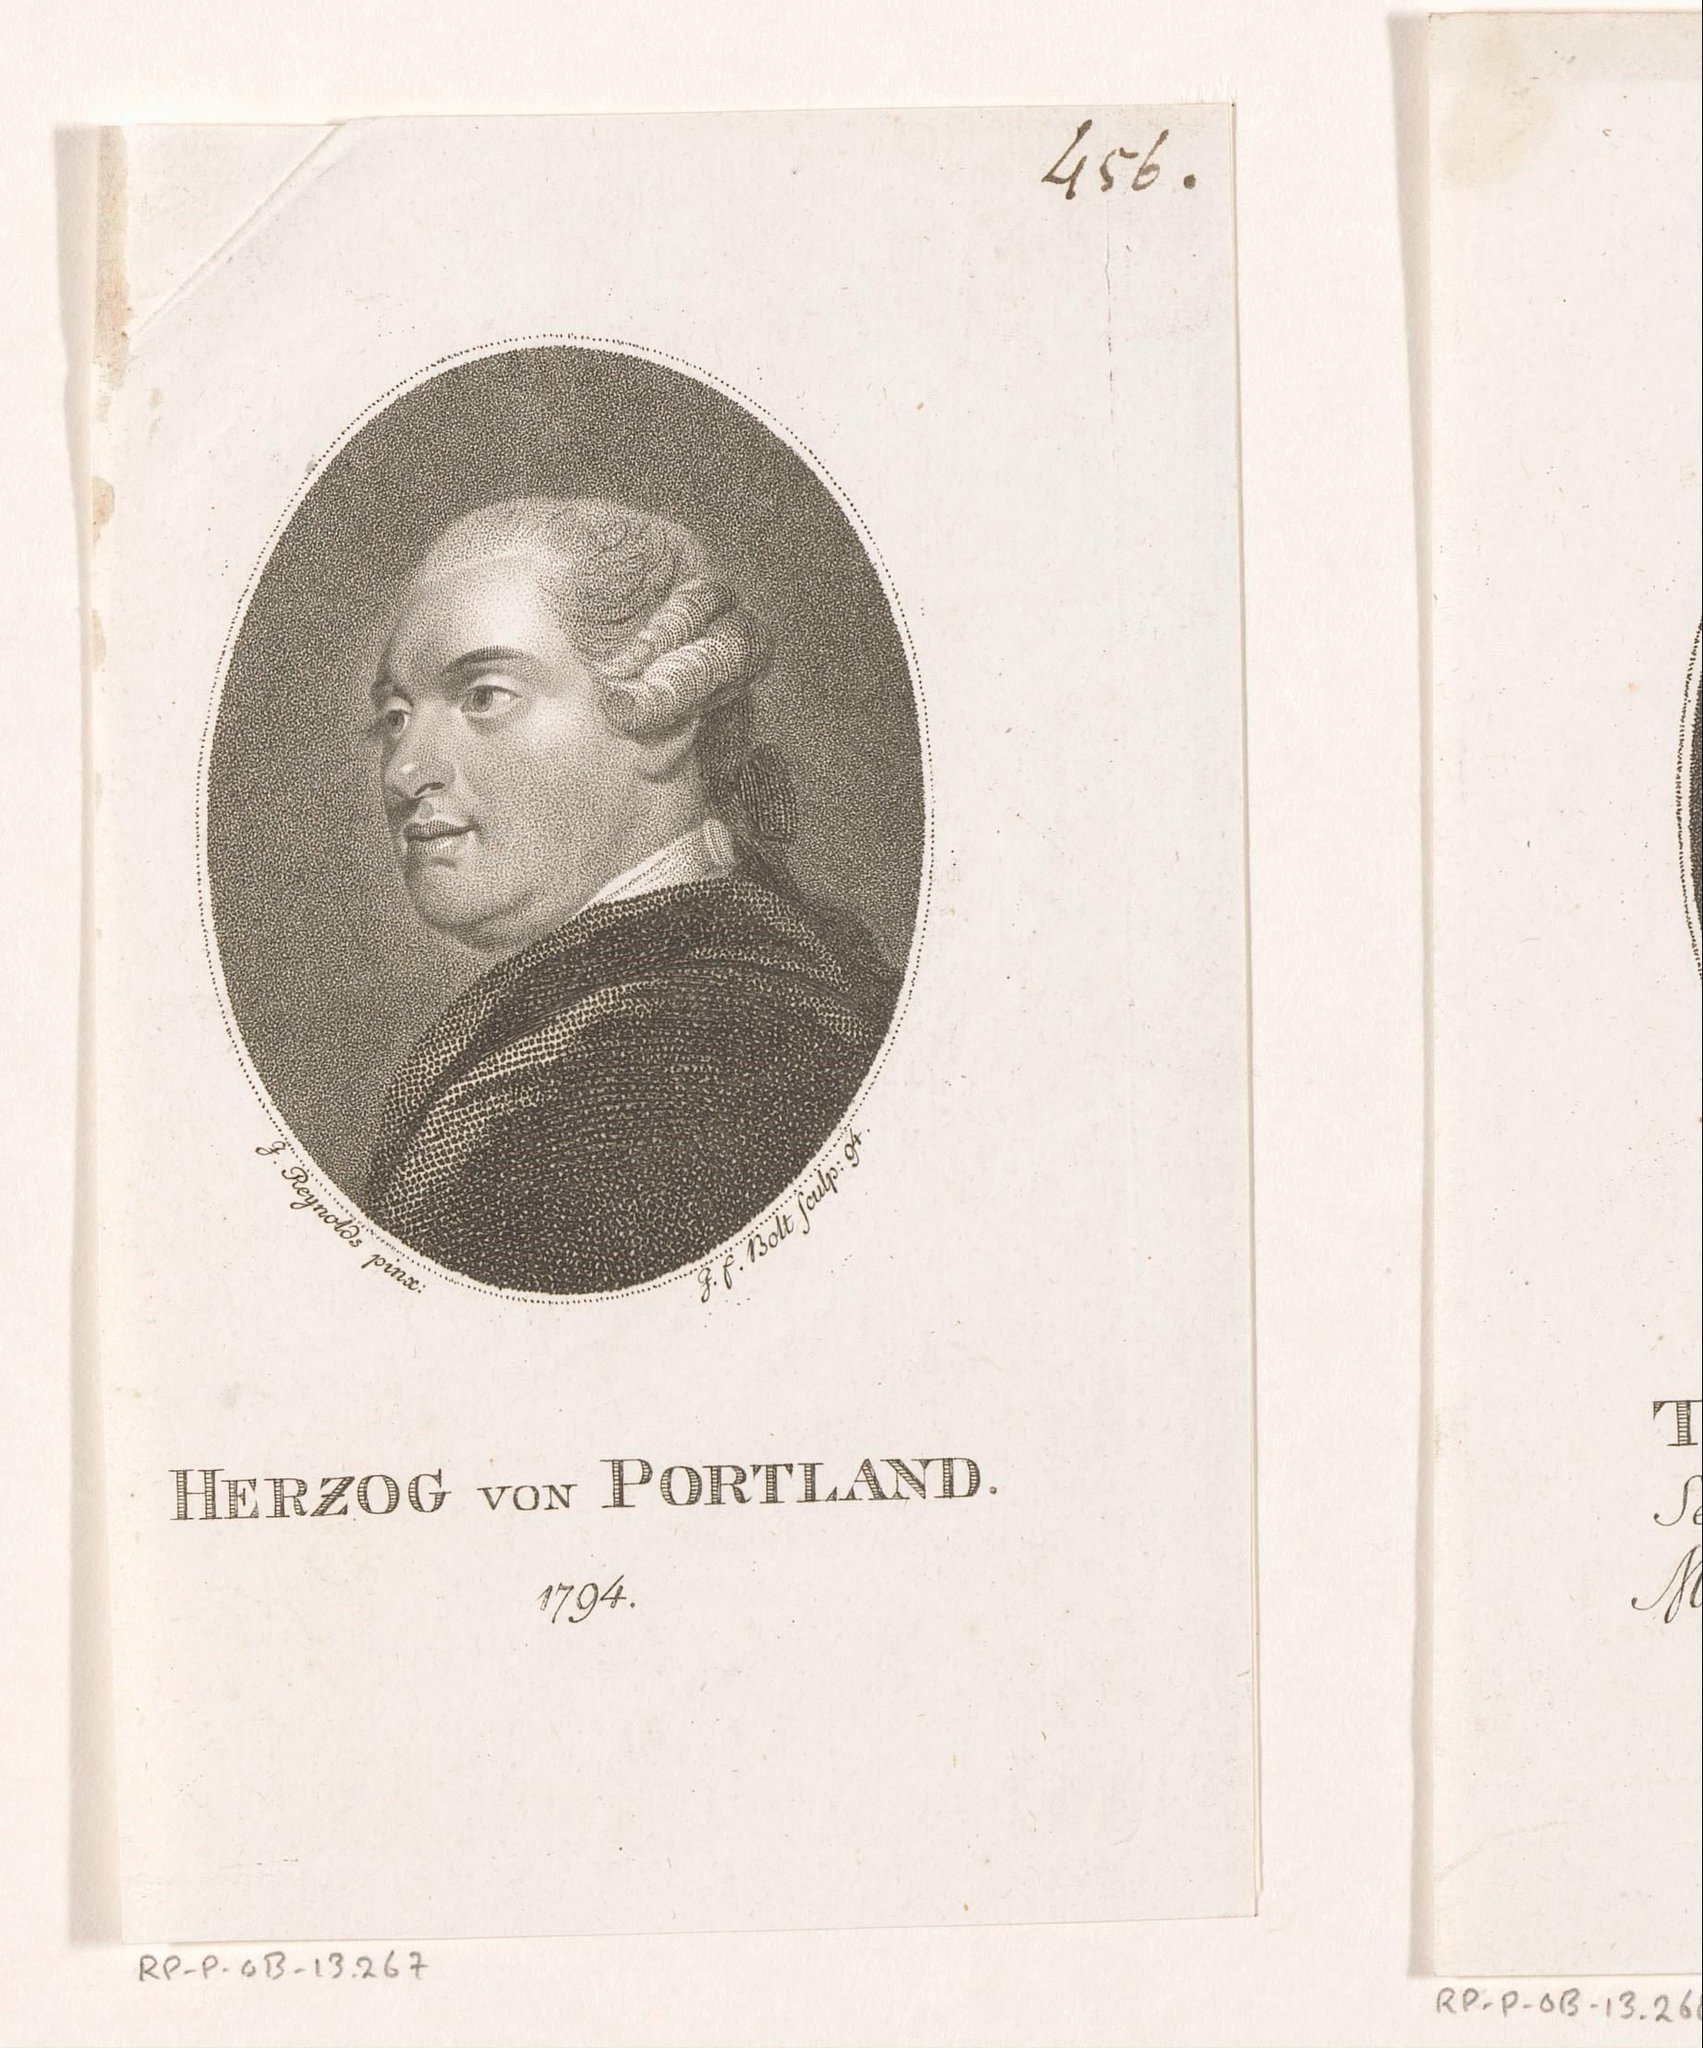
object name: print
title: Portret van William Cavendish-Bentinck, 3rd Duke of Portland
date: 1794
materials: paper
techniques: stippling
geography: hamburg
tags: historical persons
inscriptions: date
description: Prent afkomstig uit: Archenholz, Johann Wilhelm von. Annalen der Brittischen Geschichte. 19 dln. Hamburg, Johann Wilhelm von Archenholz en Benjamin Gottlob Hoffmann, 1788-1793, dl. 10 [1794].